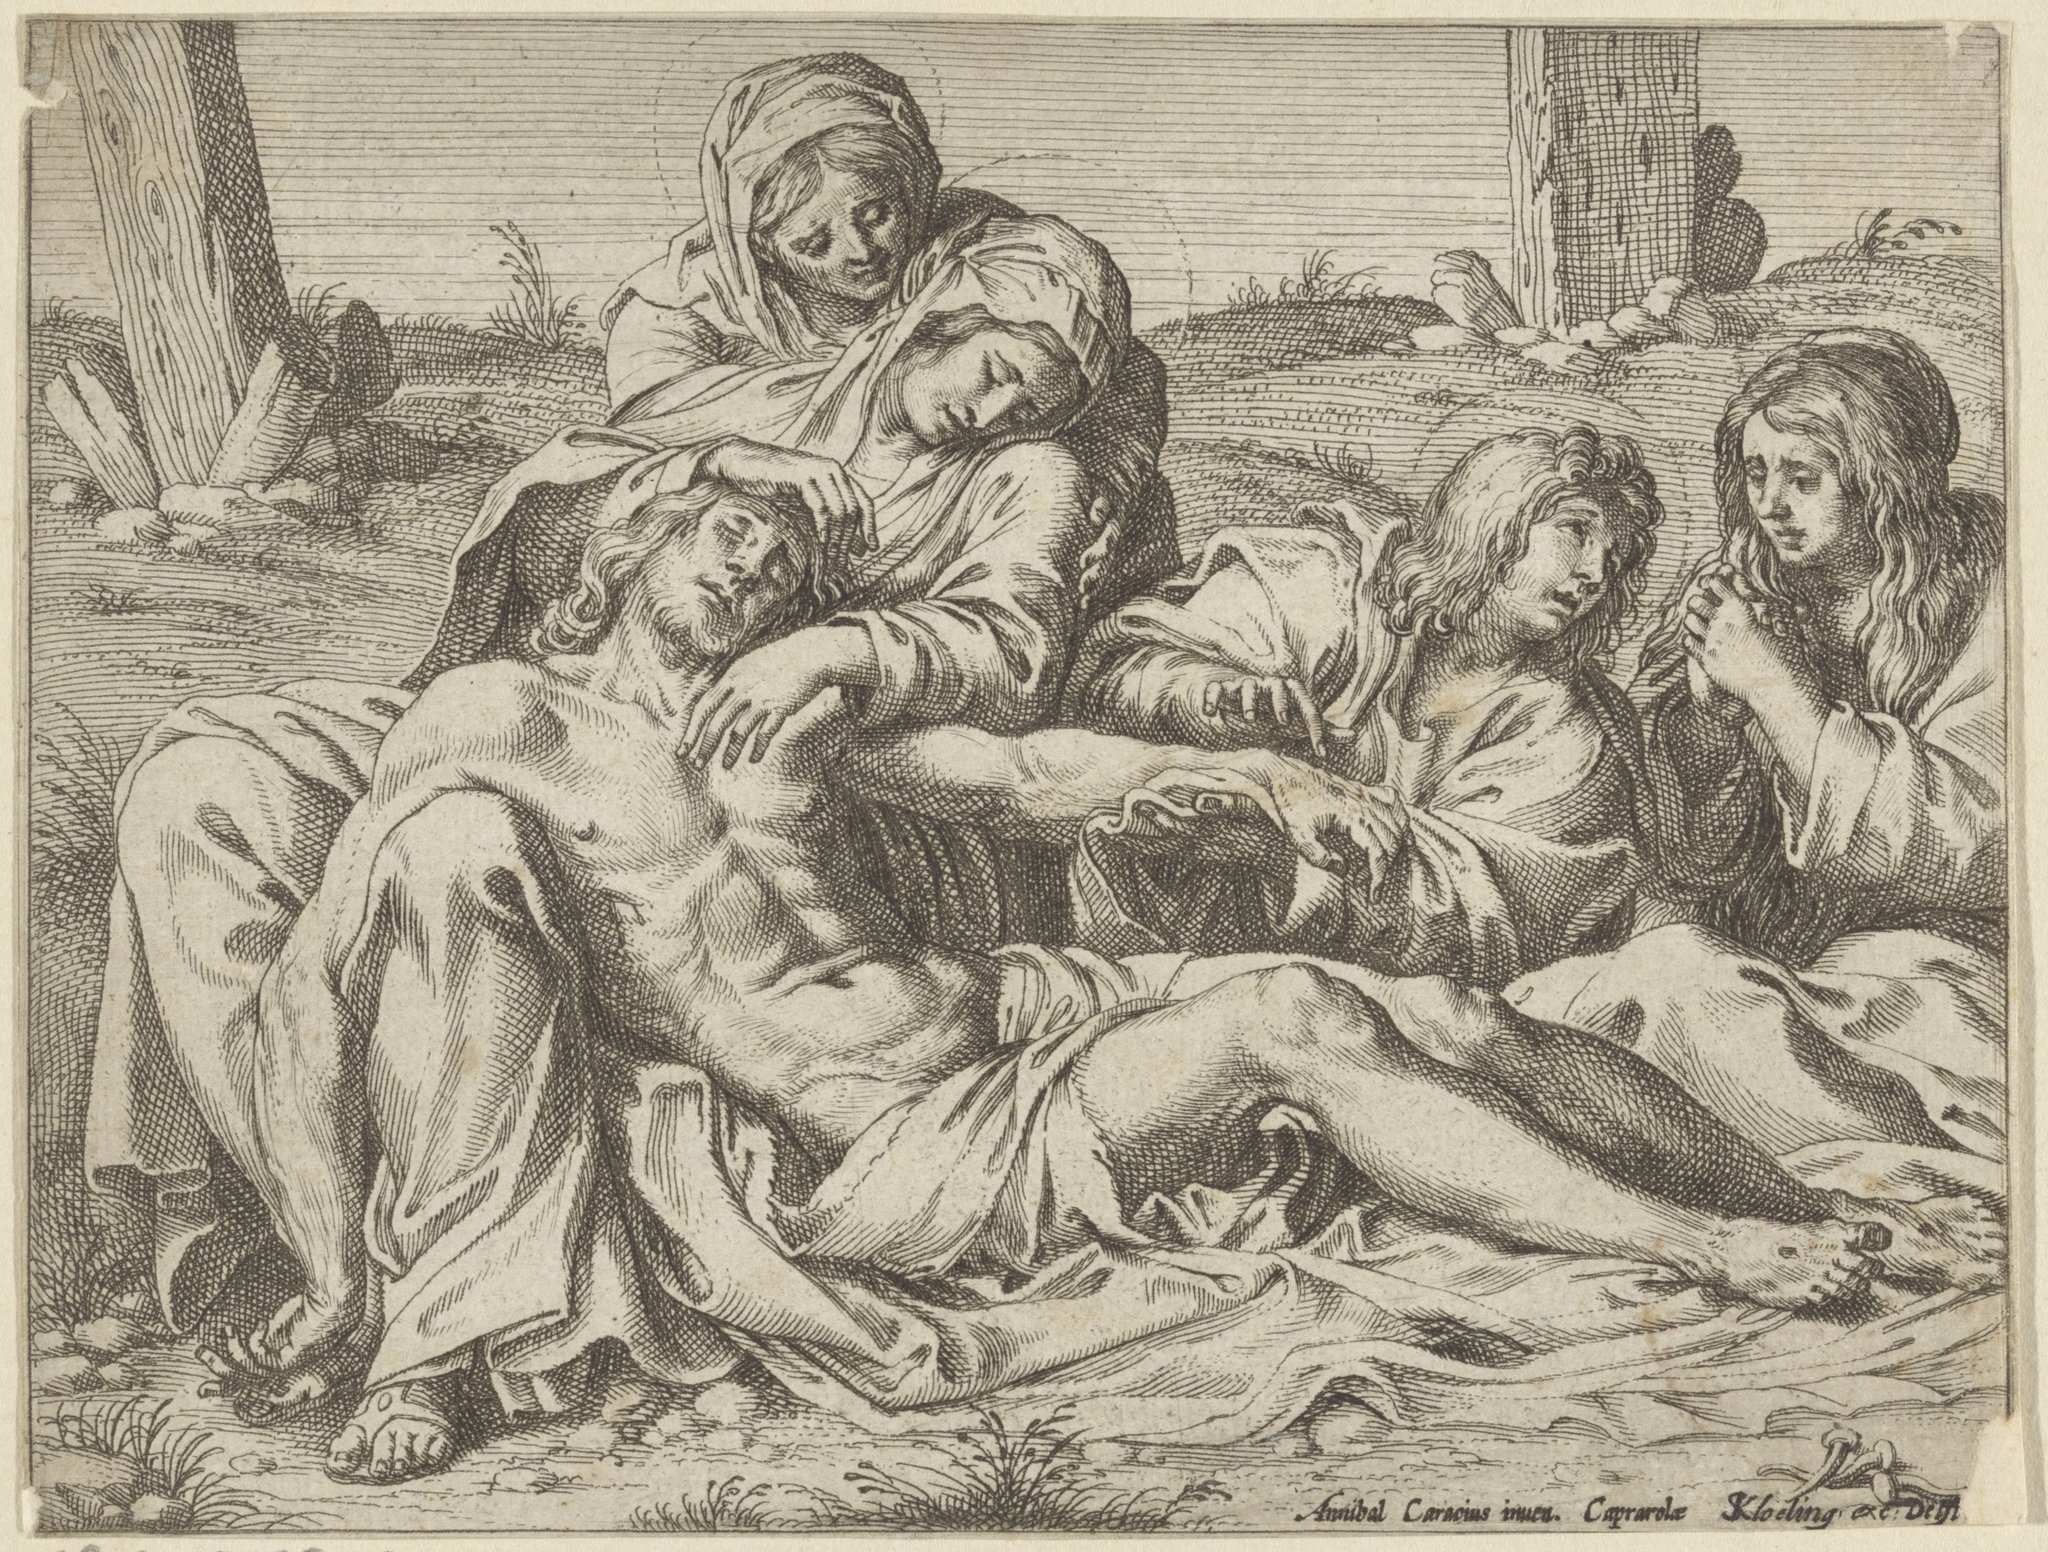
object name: print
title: Christus van Caprarola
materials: paper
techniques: engraving, etching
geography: italy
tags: the mourning over the dead christ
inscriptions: collector's mark: Lugt 240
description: De Maria's en Johannes de Evangelist treuren bij het dode lichaam van Christus.